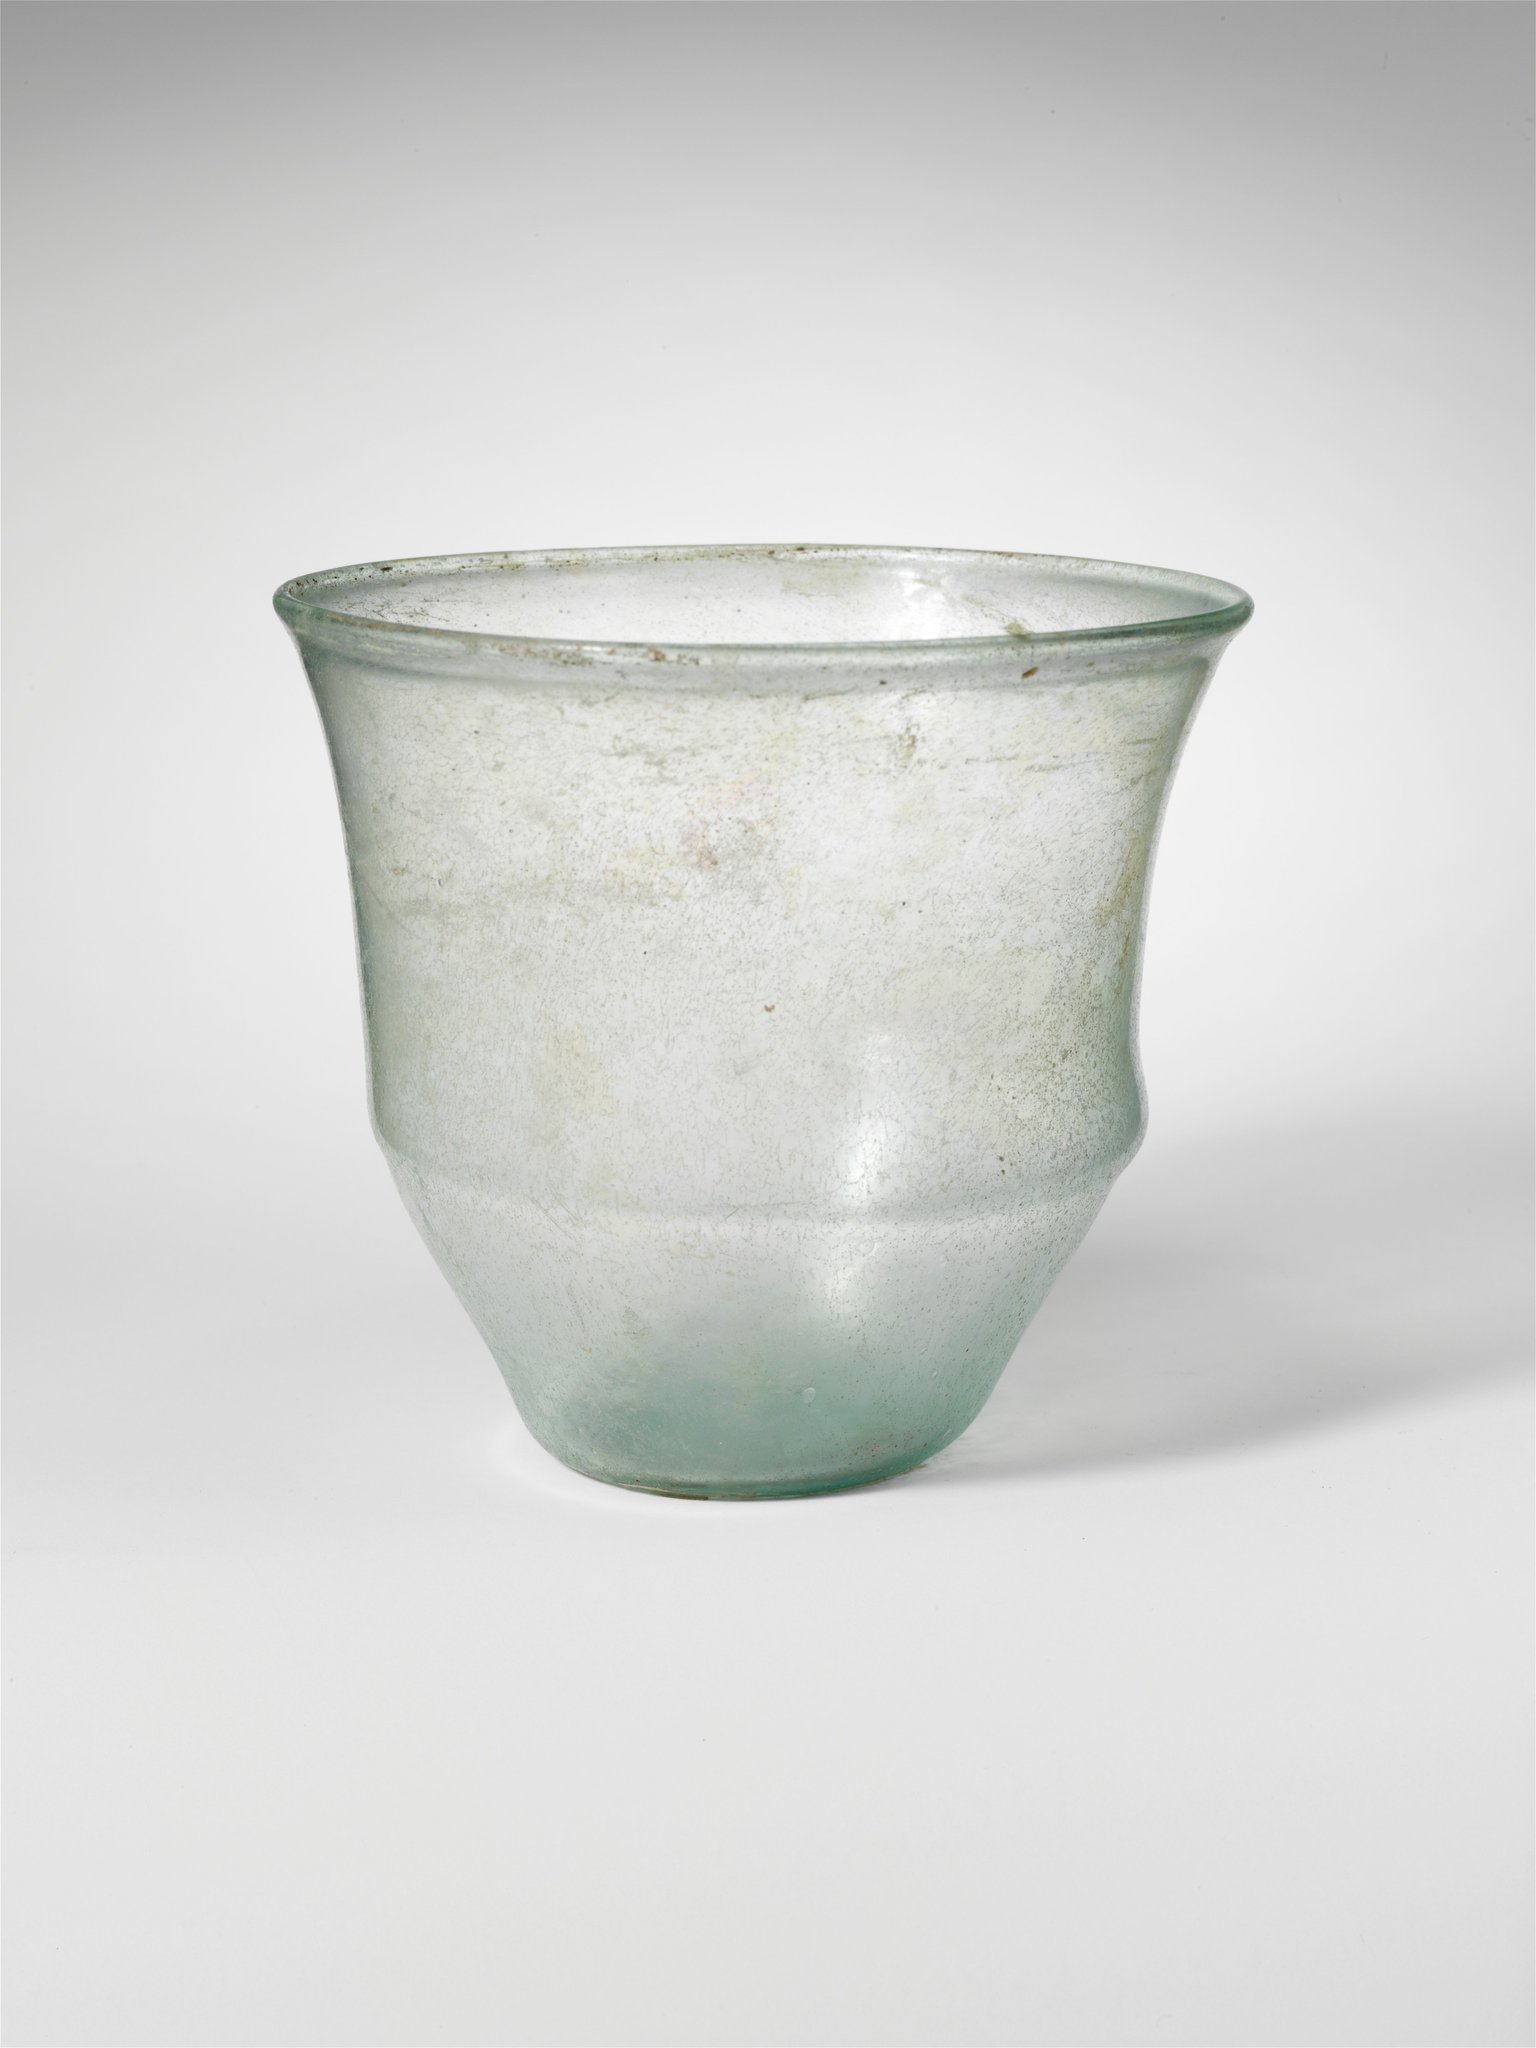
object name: cup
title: Glass cup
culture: roman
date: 1-100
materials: glass